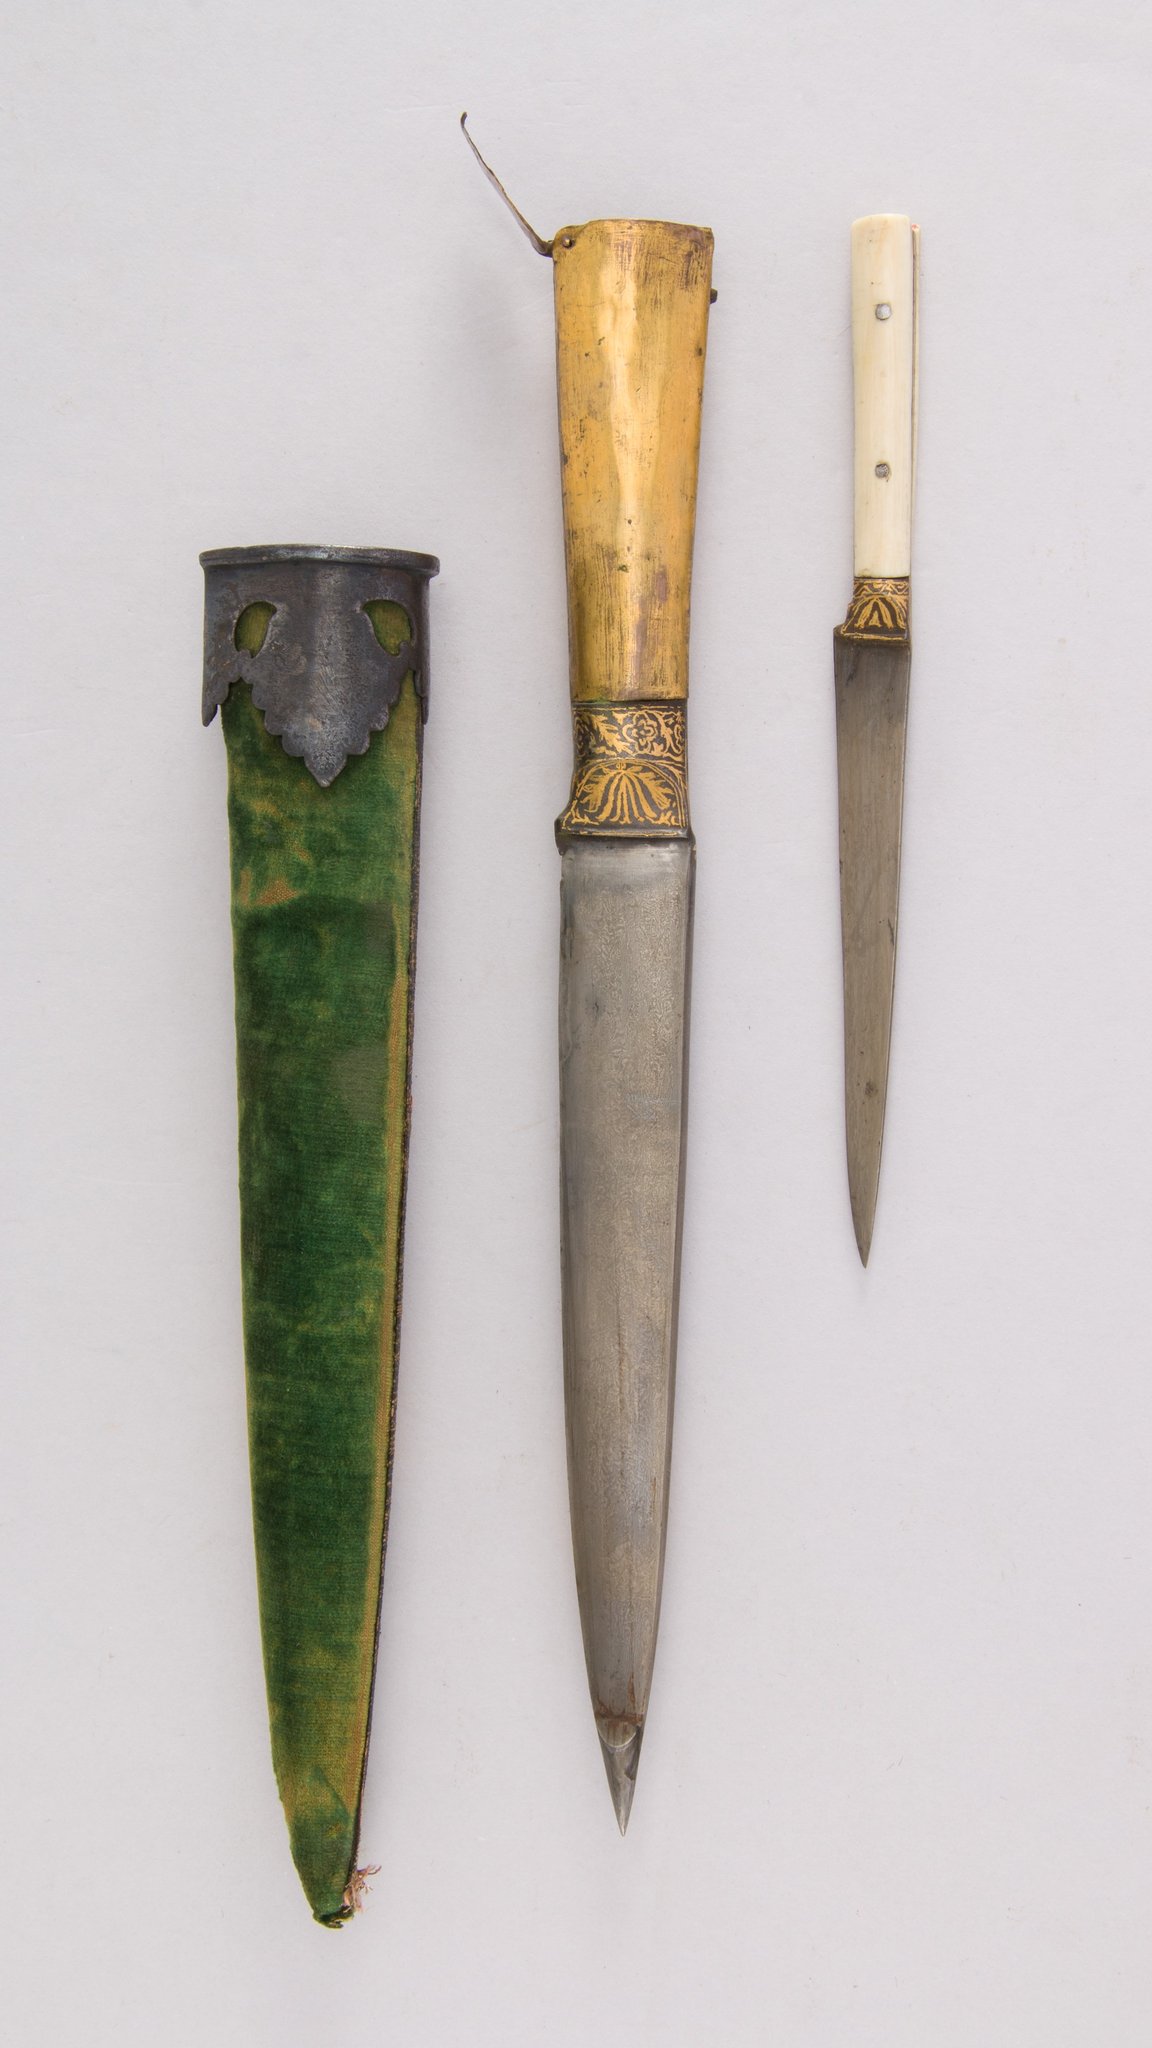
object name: knife with sheath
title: Two Knives with Sheath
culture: indian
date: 1701-1900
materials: copper, gold, iron, ivory, silver, steel, velvet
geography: india